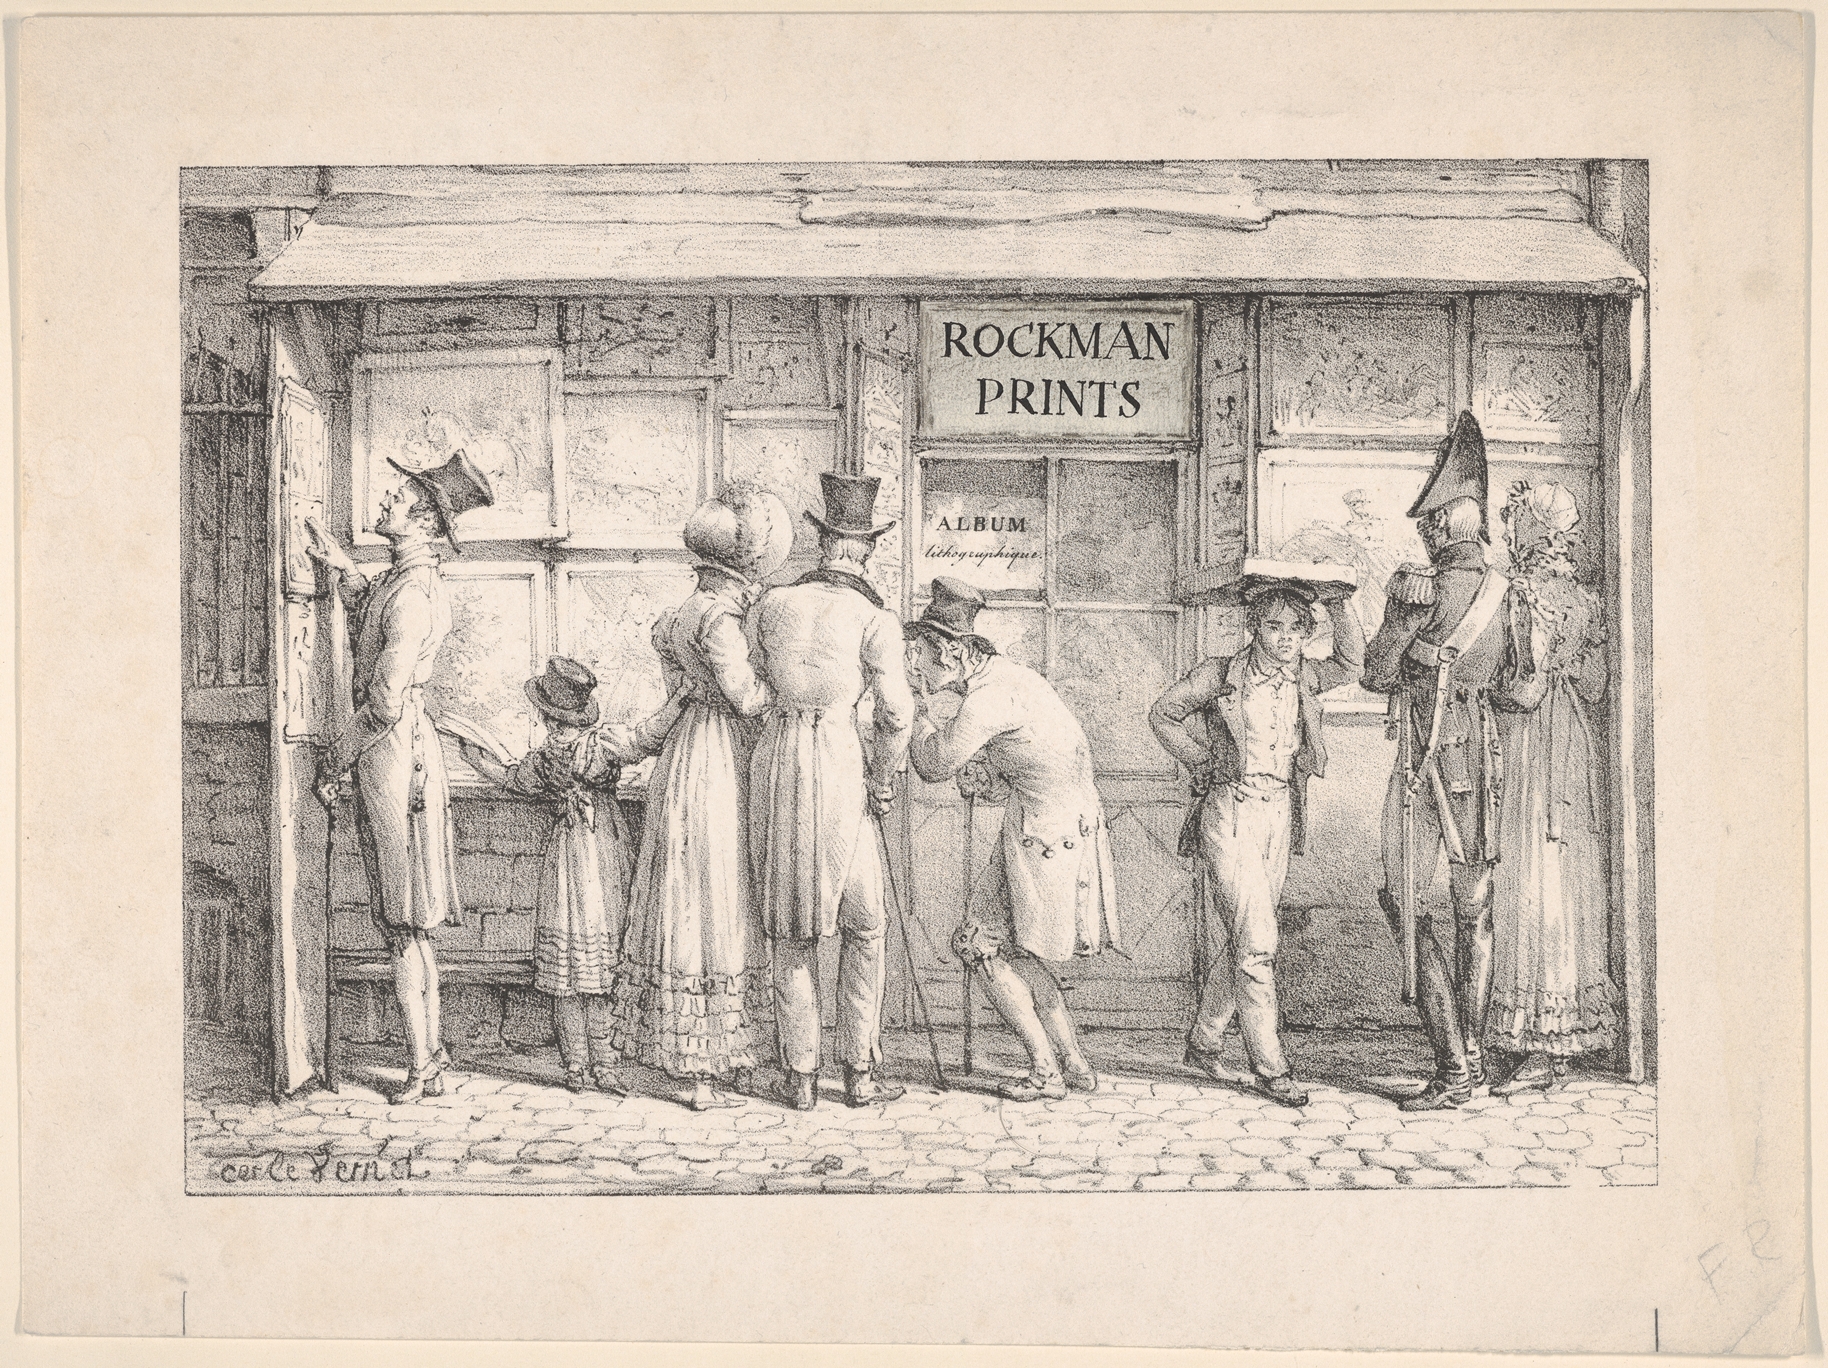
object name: print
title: François Delpech's Print Shop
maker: carle vernet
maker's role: artist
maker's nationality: french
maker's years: 1758-1836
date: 1820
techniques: lithograph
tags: men,women